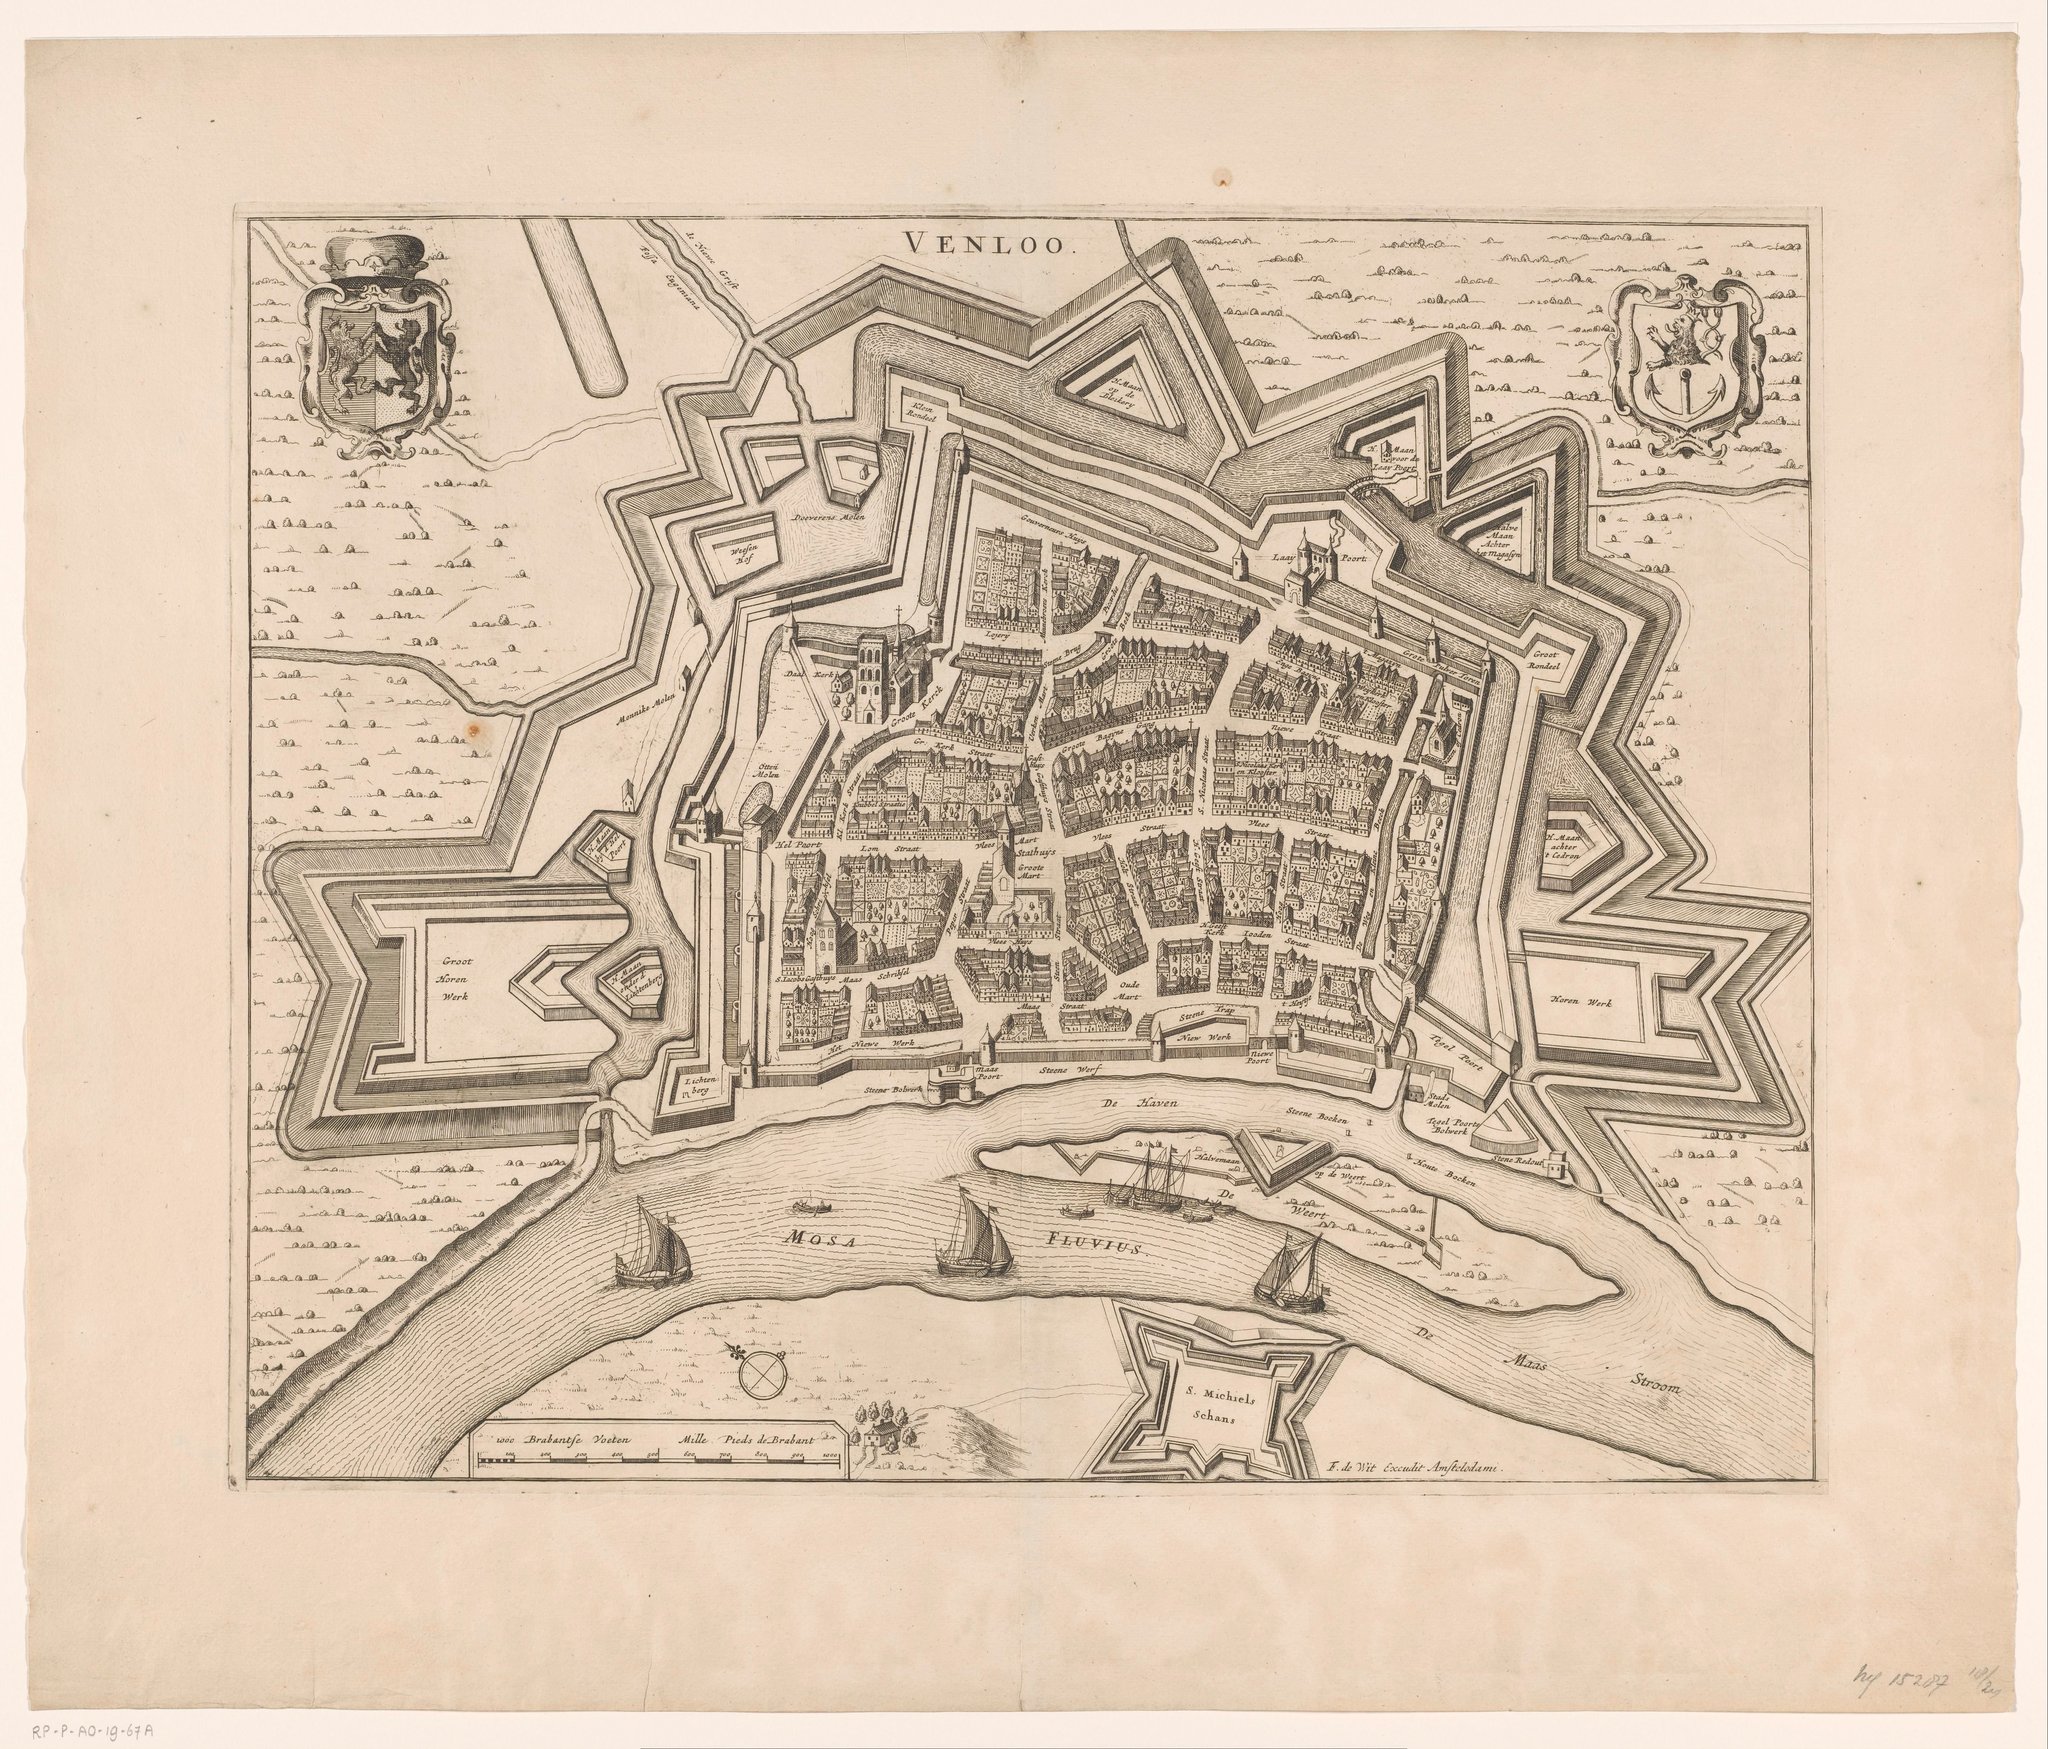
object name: area plan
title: Plattegrond van Venlo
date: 1700-1710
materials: paper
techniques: engraving, etching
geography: amsterdam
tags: coat of arms (as symbol of the state, etc.) (+ city; municipal), fortified city, maps of cities, coat of arms (as symbol of the state, etc.) (+ province; provincial)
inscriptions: collector's mark: Lugt 2228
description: Plattegrond van Venlo met gebouwen in vogelvluchtperspectief. Boven, in het midden, de titel. Onder, links van het midden, een kader met een schaalstok: 1000 Brabantse Voeten. Linksboven het wapen van het hertogdom Gelre, rechtsboven het wapen van Venlo.